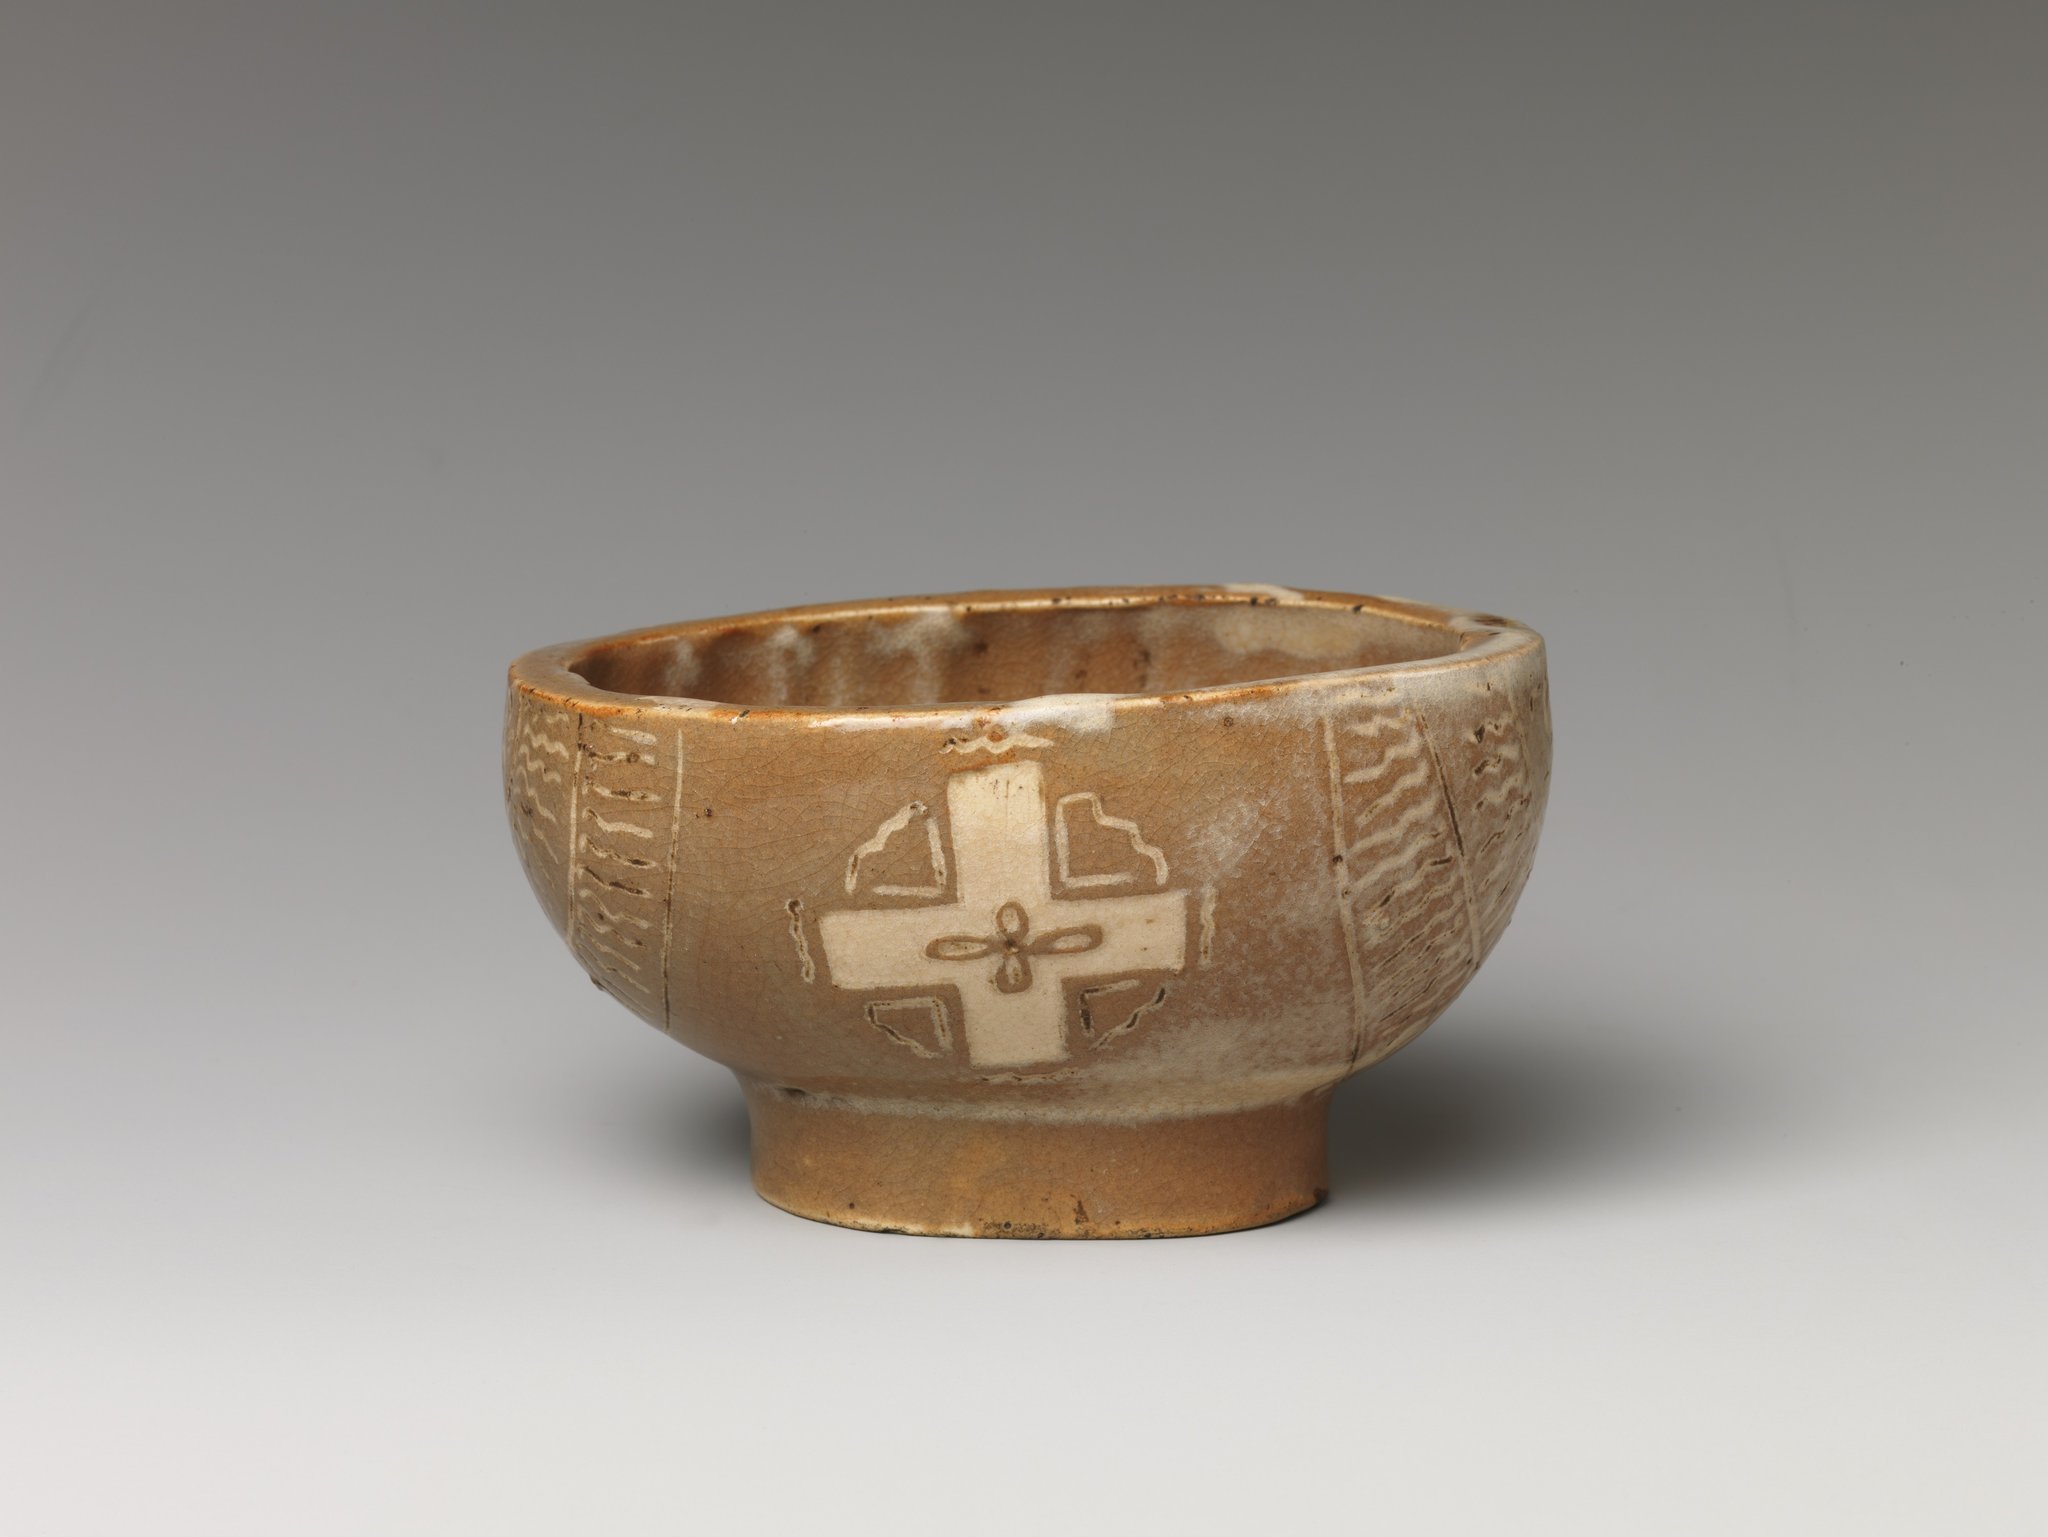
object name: bowl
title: Bowl with Cross Decoration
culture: japanese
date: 1801-1900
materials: stoneware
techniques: inlay